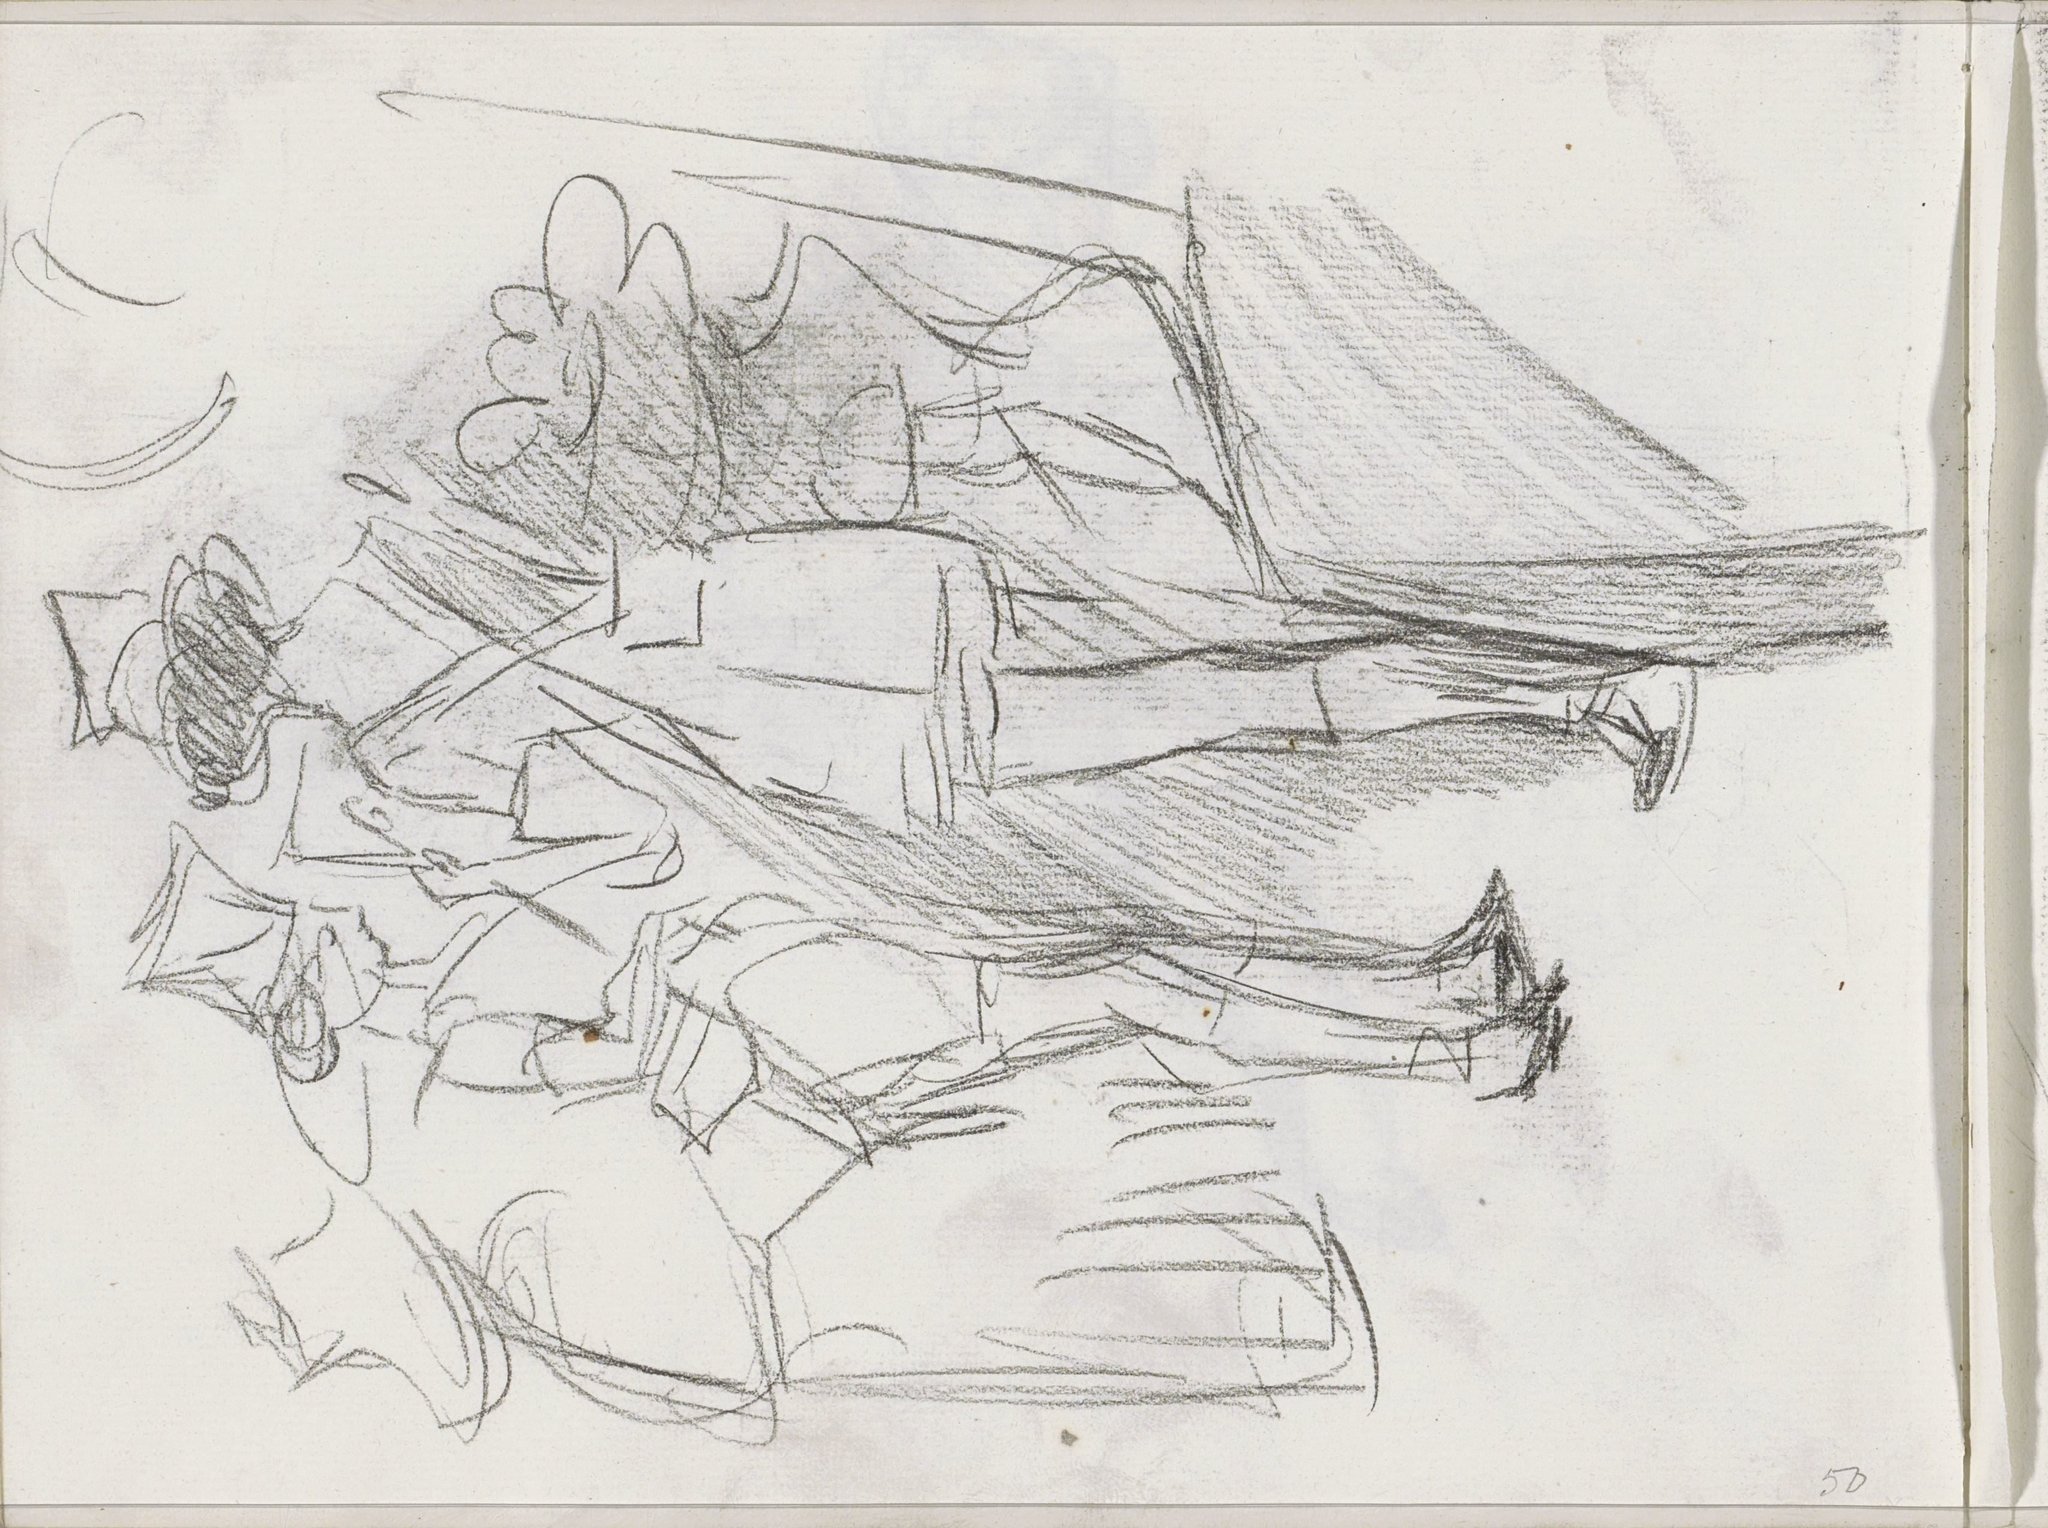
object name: sketchbook leaf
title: Staande vrouwen, mogelijk variétéartiesten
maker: isaac israels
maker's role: draughtsman, painter, print maker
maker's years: 1865-1934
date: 1875-1934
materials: chalk, paper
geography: the hague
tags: stage costume, adult woman (+ standing)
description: Blad 19 verso uit schetsboek XXII met 30 bladen.